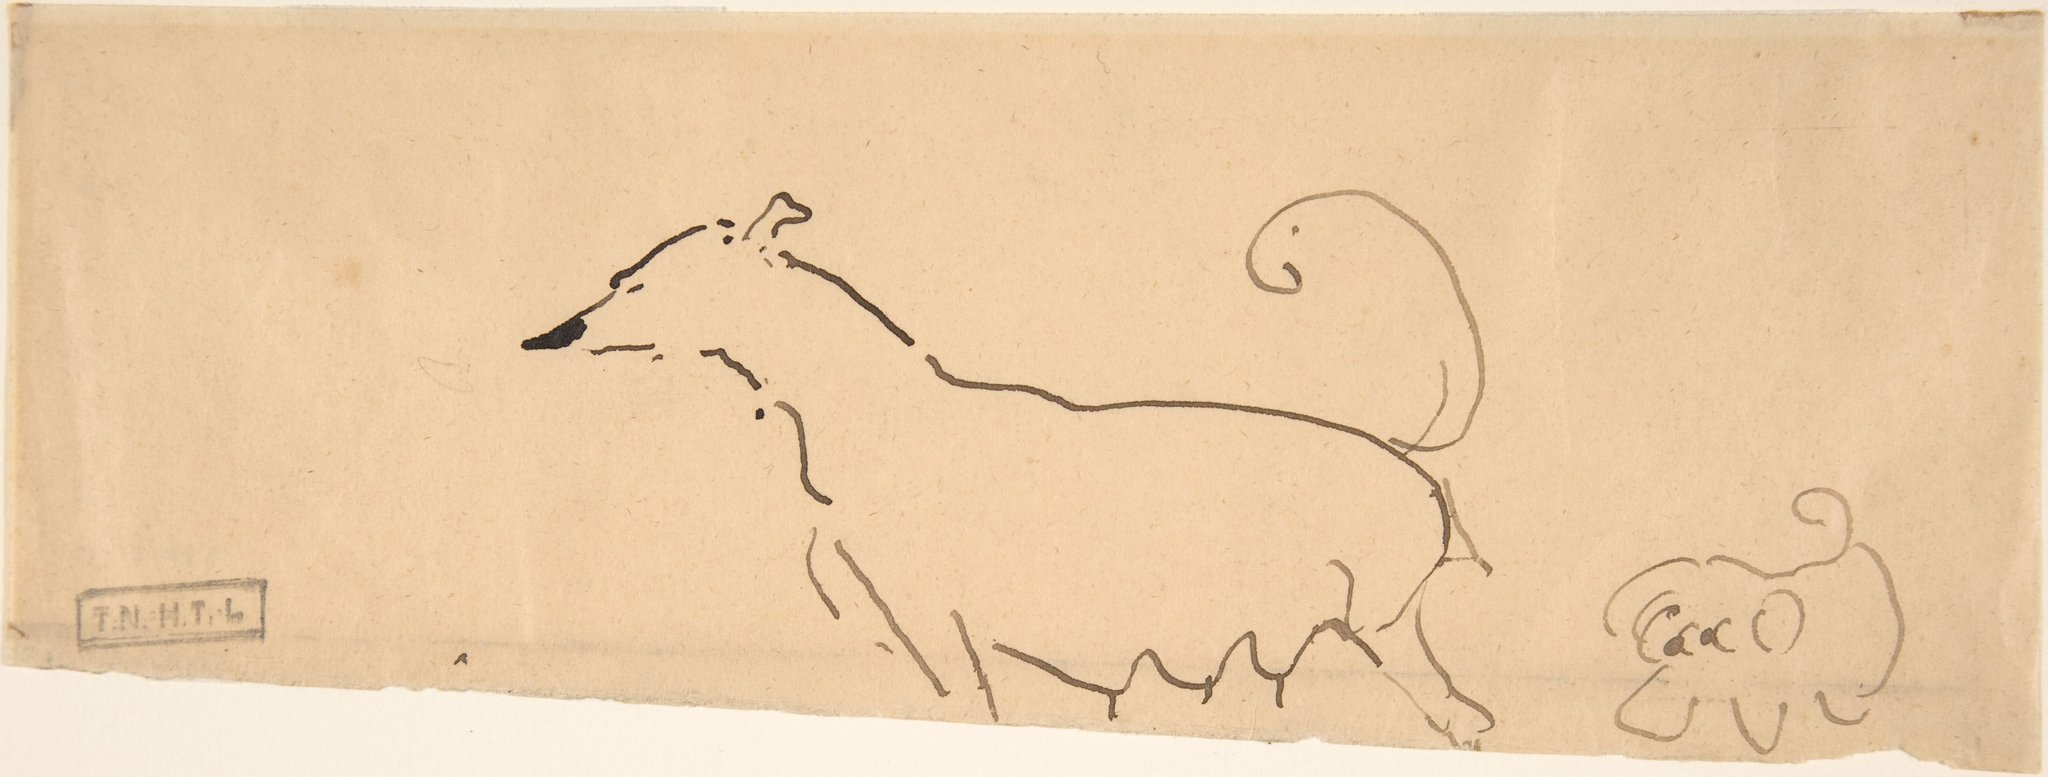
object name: drawing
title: Two Dogs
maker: henri de toulouse-lautrec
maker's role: artist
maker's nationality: french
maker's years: 1864-1901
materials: ink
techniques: pen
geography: france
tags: dogs